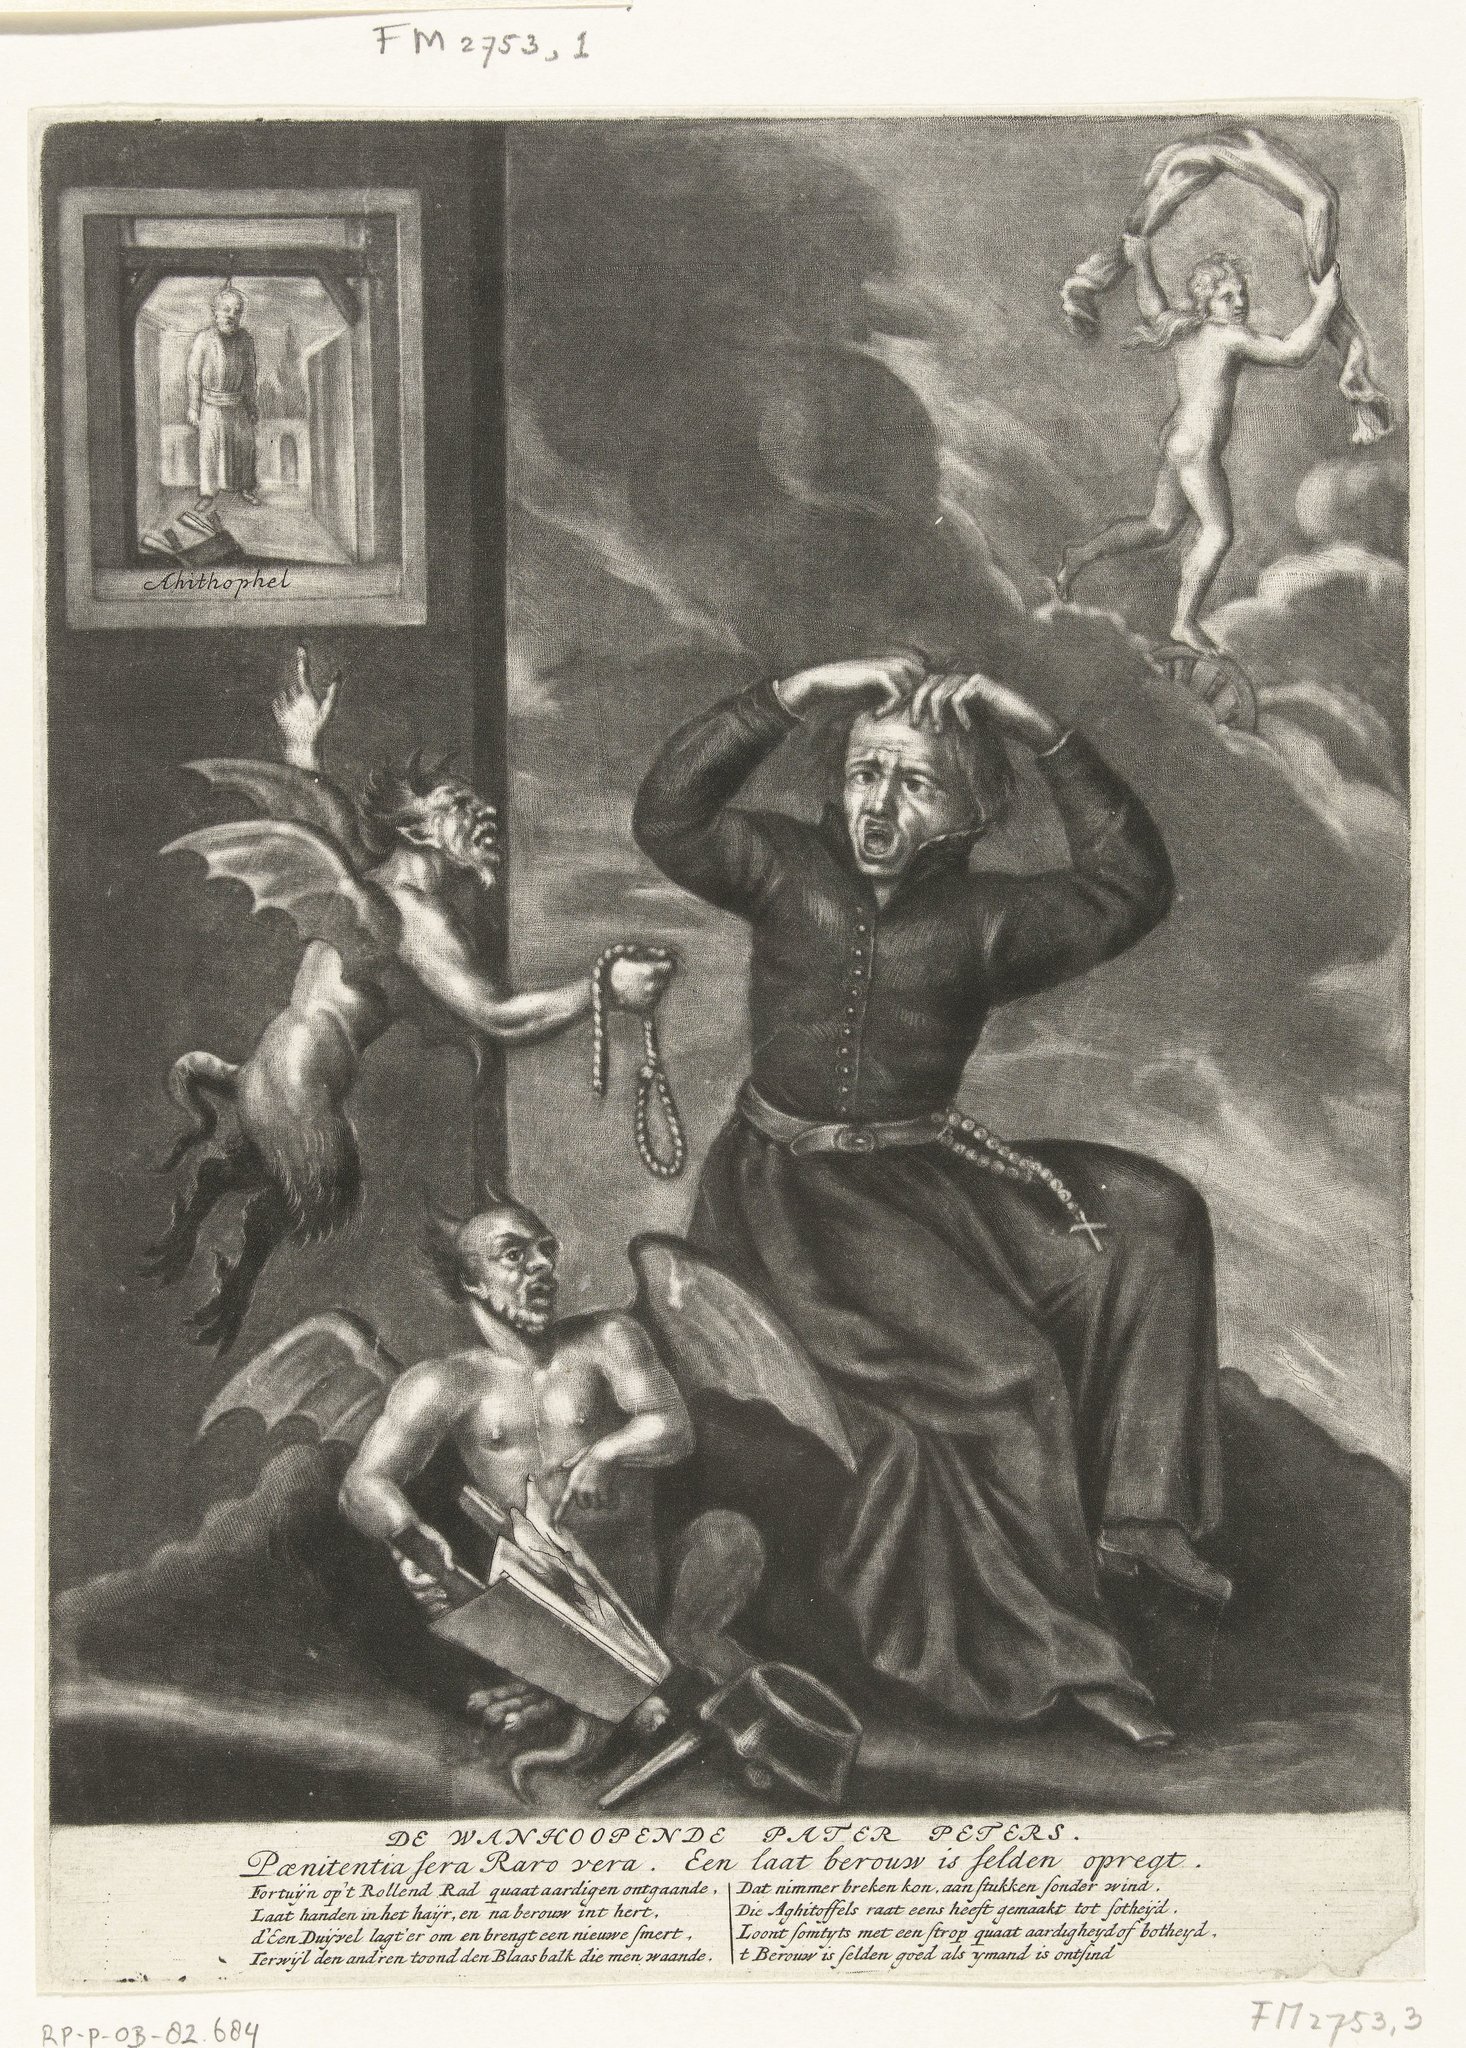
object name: print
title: De Wanhoopende Pater Peters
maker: Anonymous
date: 1689-1690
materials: paper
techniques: mezzotint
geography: northern netherlands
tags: ahitophel hangs himself, devil(s) and demons, despair; 'disperatione' (ripa), luck, fortune, lot; 'fato', 'fortuna', 'fortuna aurea', 'fortuna buona', 'fortuna pacifica overo clemente', 'sorte' (ripa)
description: Spotprent op pater Peters (Edward Petre), 1689. De jezuïet zit wanhopend op een ashoop, links zit een duivel met een gebroken blaasbalg, daarboven vliegt een andere duivel die Peters een strop aanbiedt en wijst op een afbeelding van Achitofel die zich heeft opgehangen. In de lucht Fortuna. In het onderschrift 2 verzen van 4 regels en de spreuk: Een laat berouw is selden opregt.